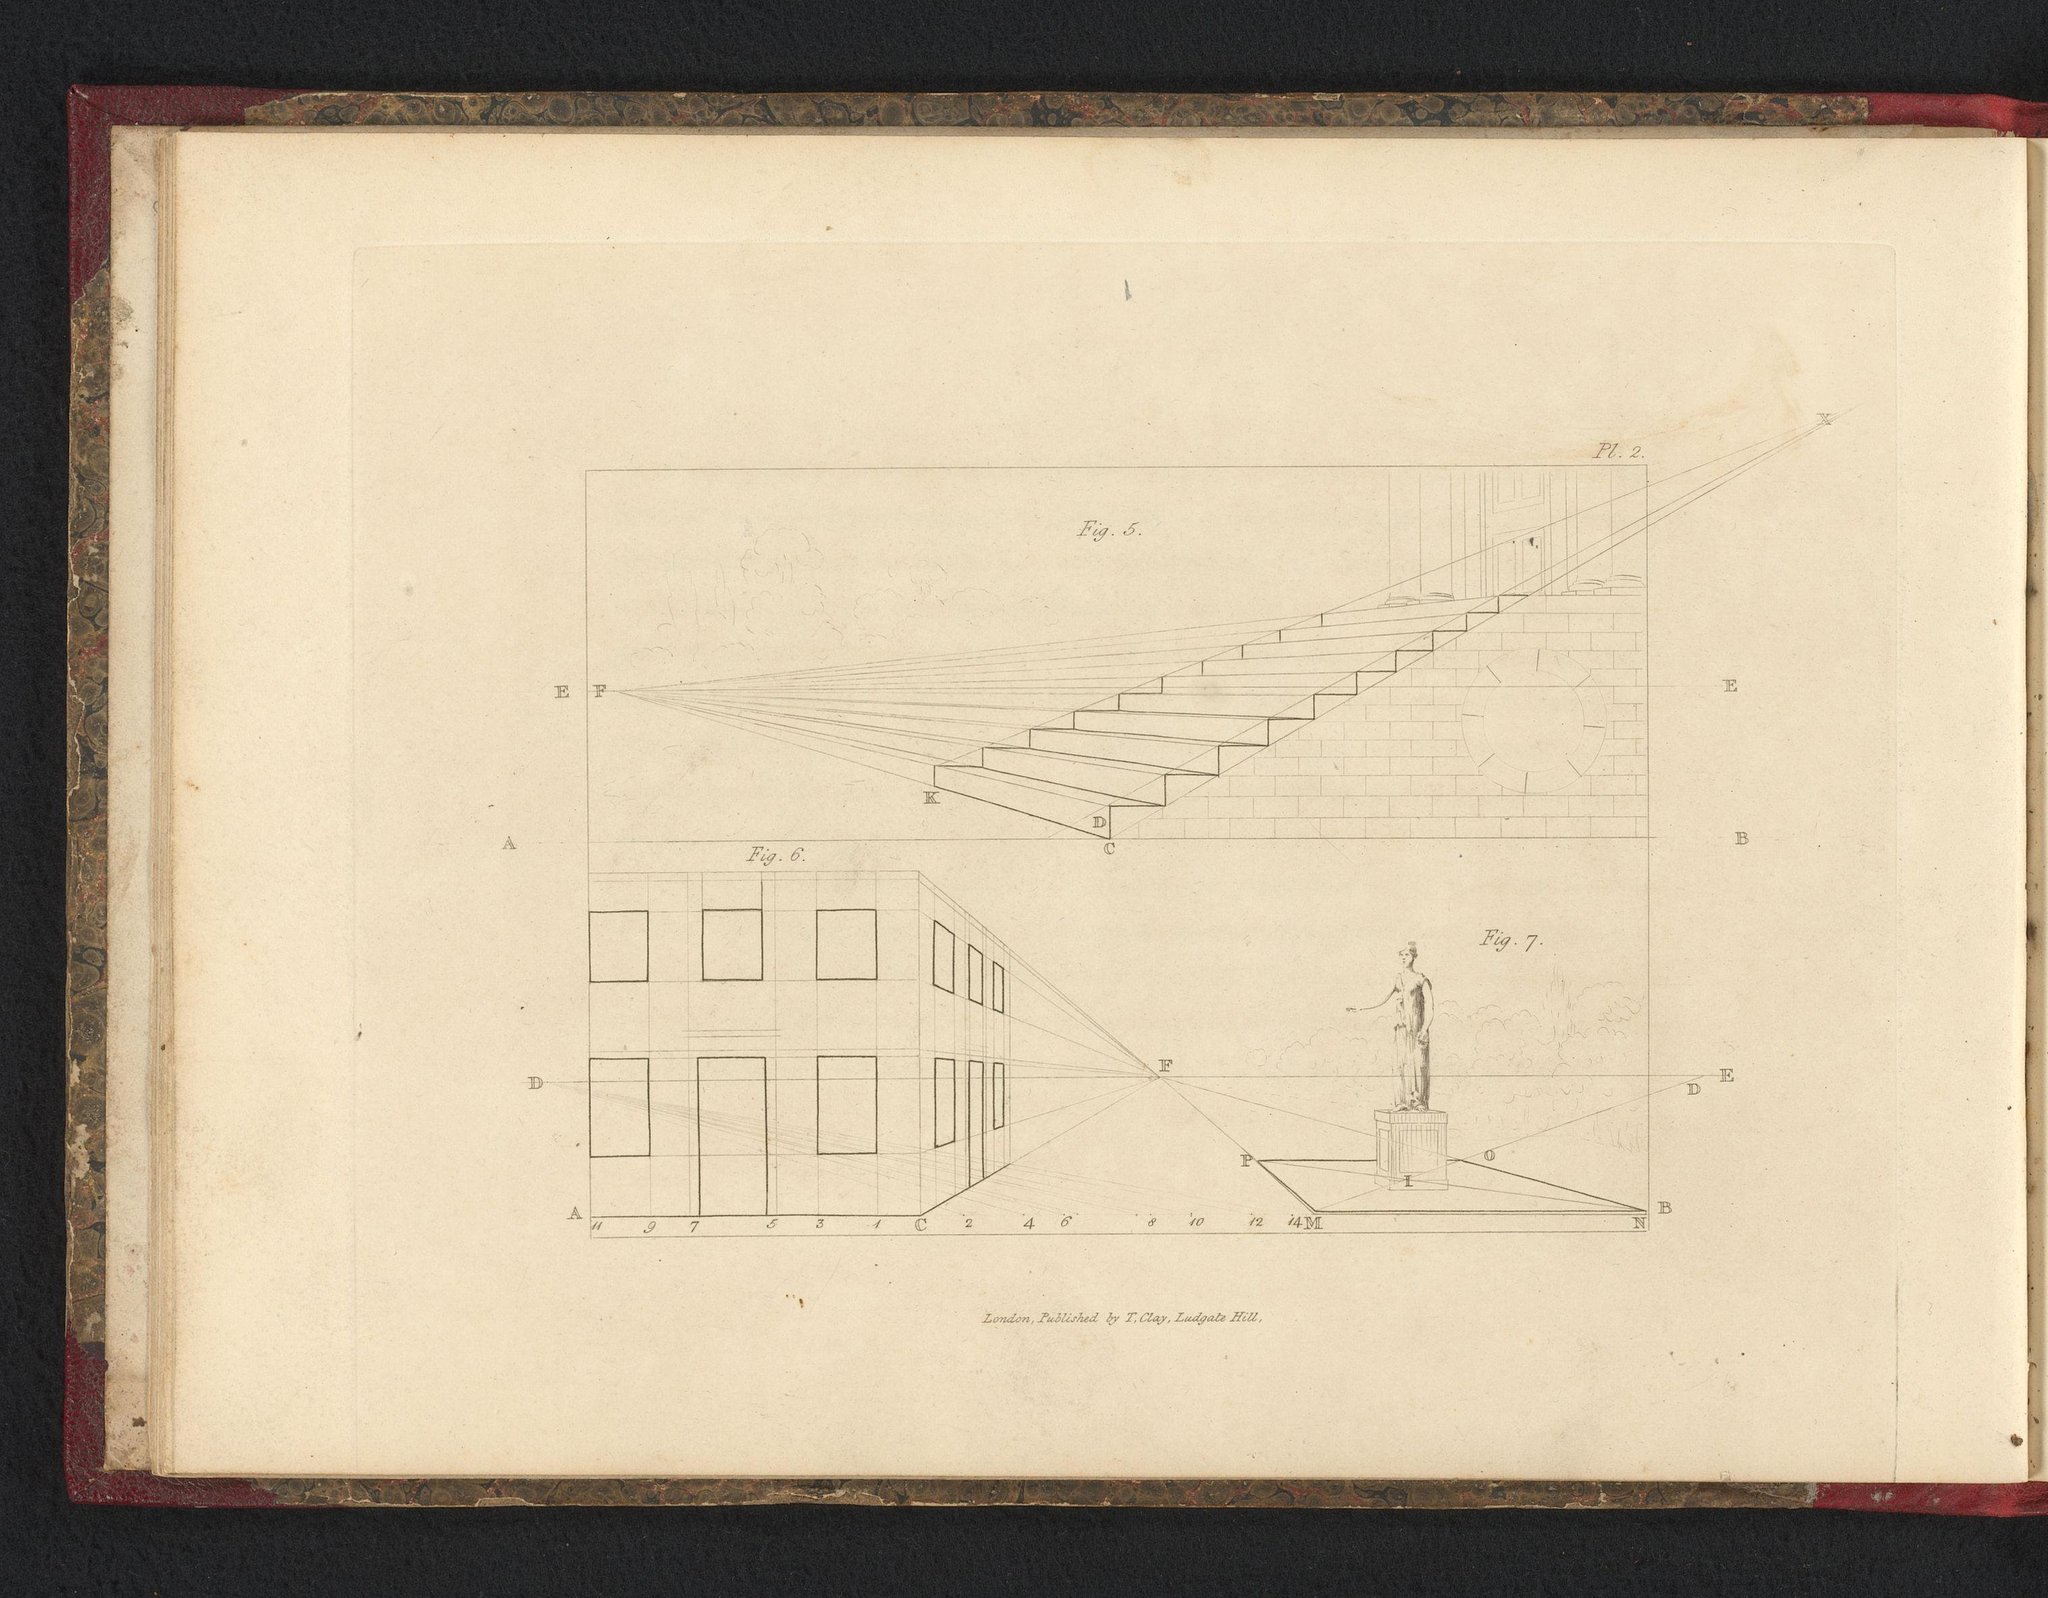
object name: page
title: Drie figuren waarop perspectief in een landschap is weergegeven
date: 1828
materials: paper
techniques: engraving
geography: london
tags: terrace, painting (including book-illumination, miniature-painting), 'perspective' (alleg.); 'prospetiva' (ripa)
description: Genummerd: Pl. 2. Prent maakt deel uit van een boek.